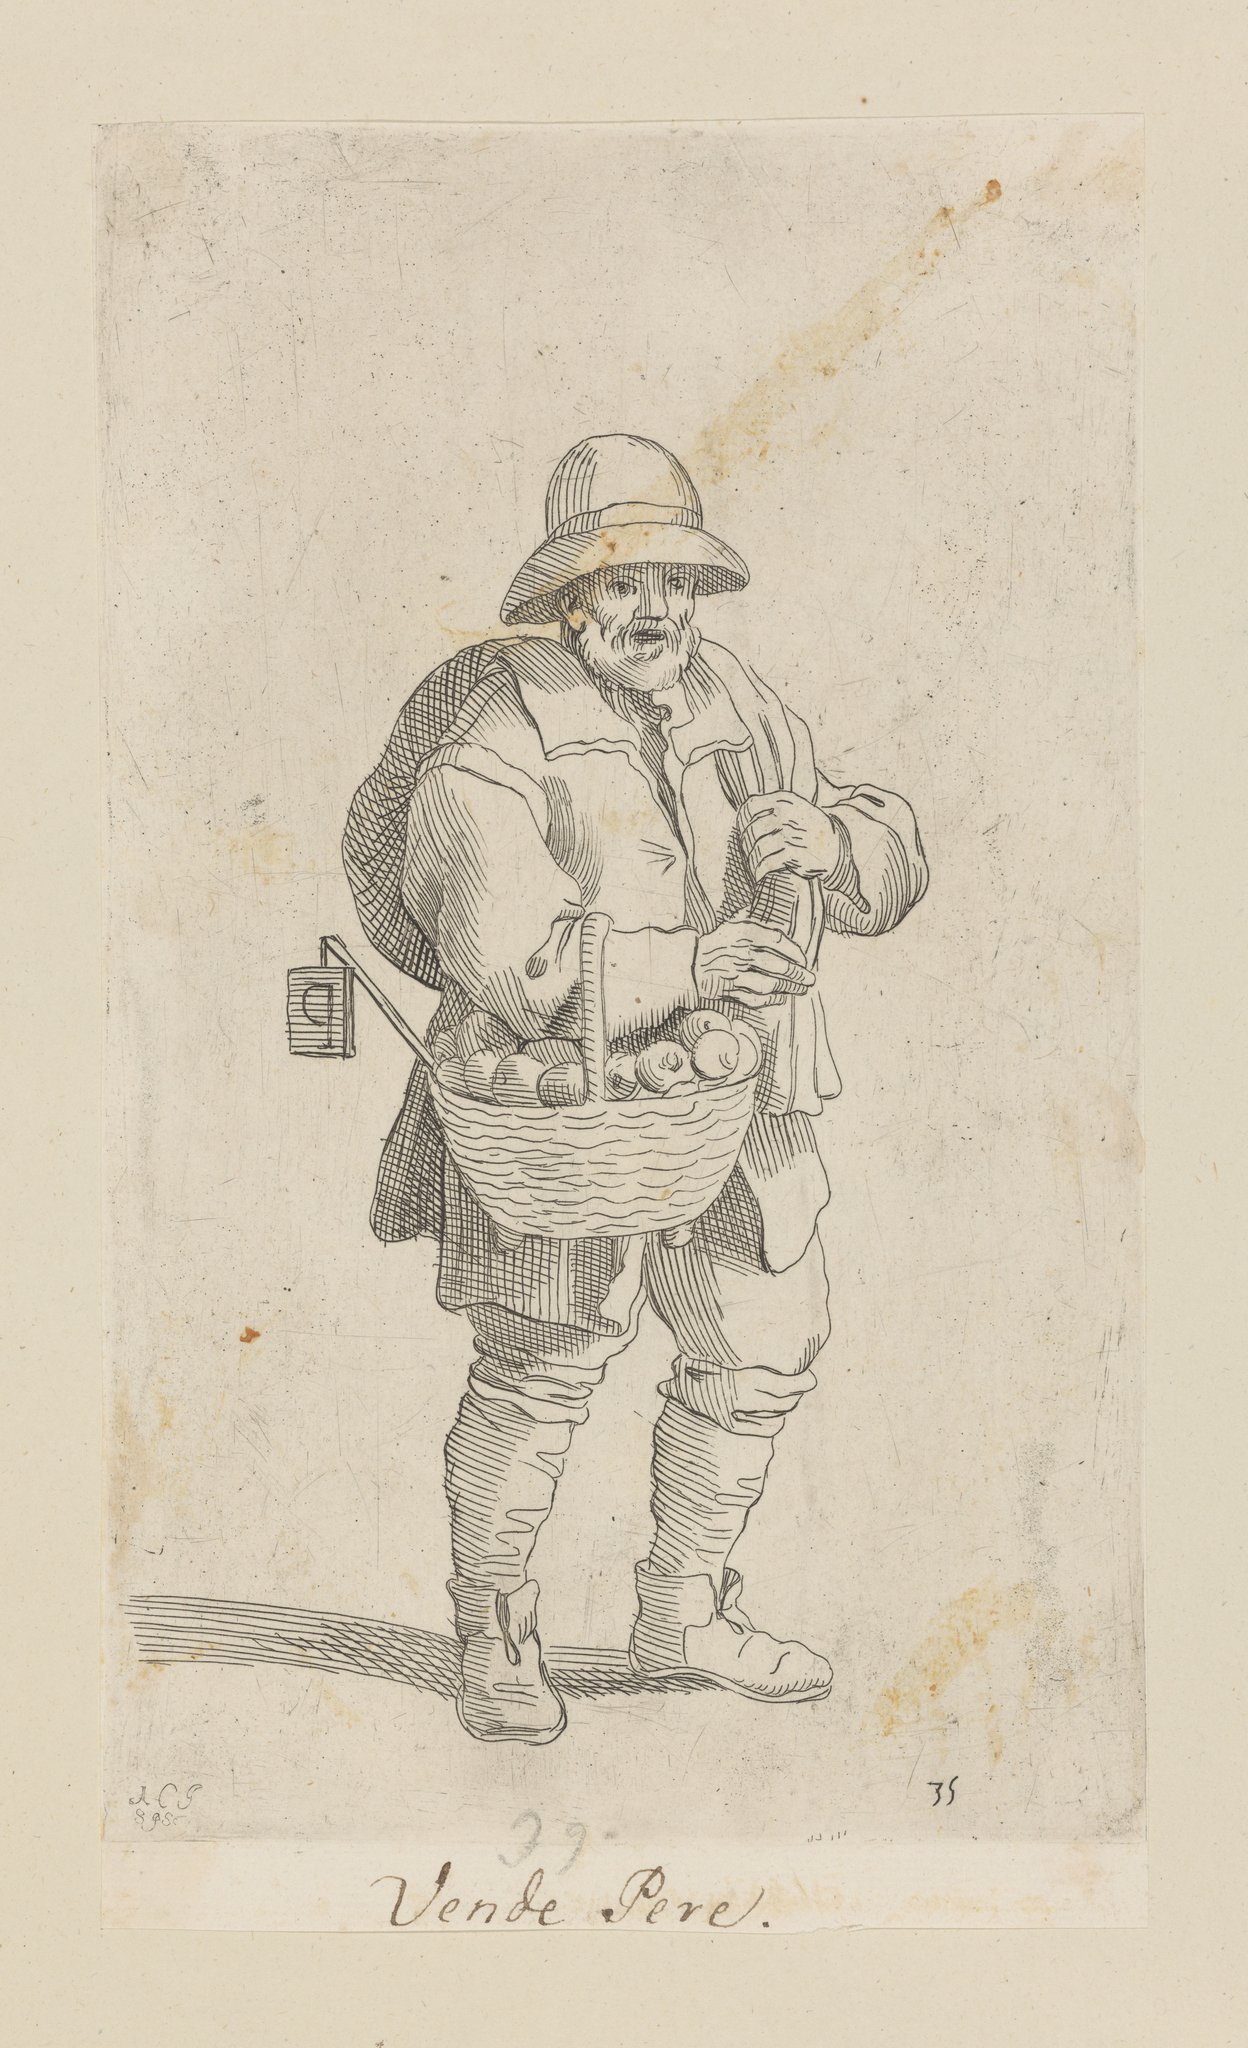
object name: print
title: Plate 35: Pear vendor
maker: simon guillain ii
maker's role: artist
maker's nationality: french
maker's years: 1618-1718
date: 1646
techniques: etching